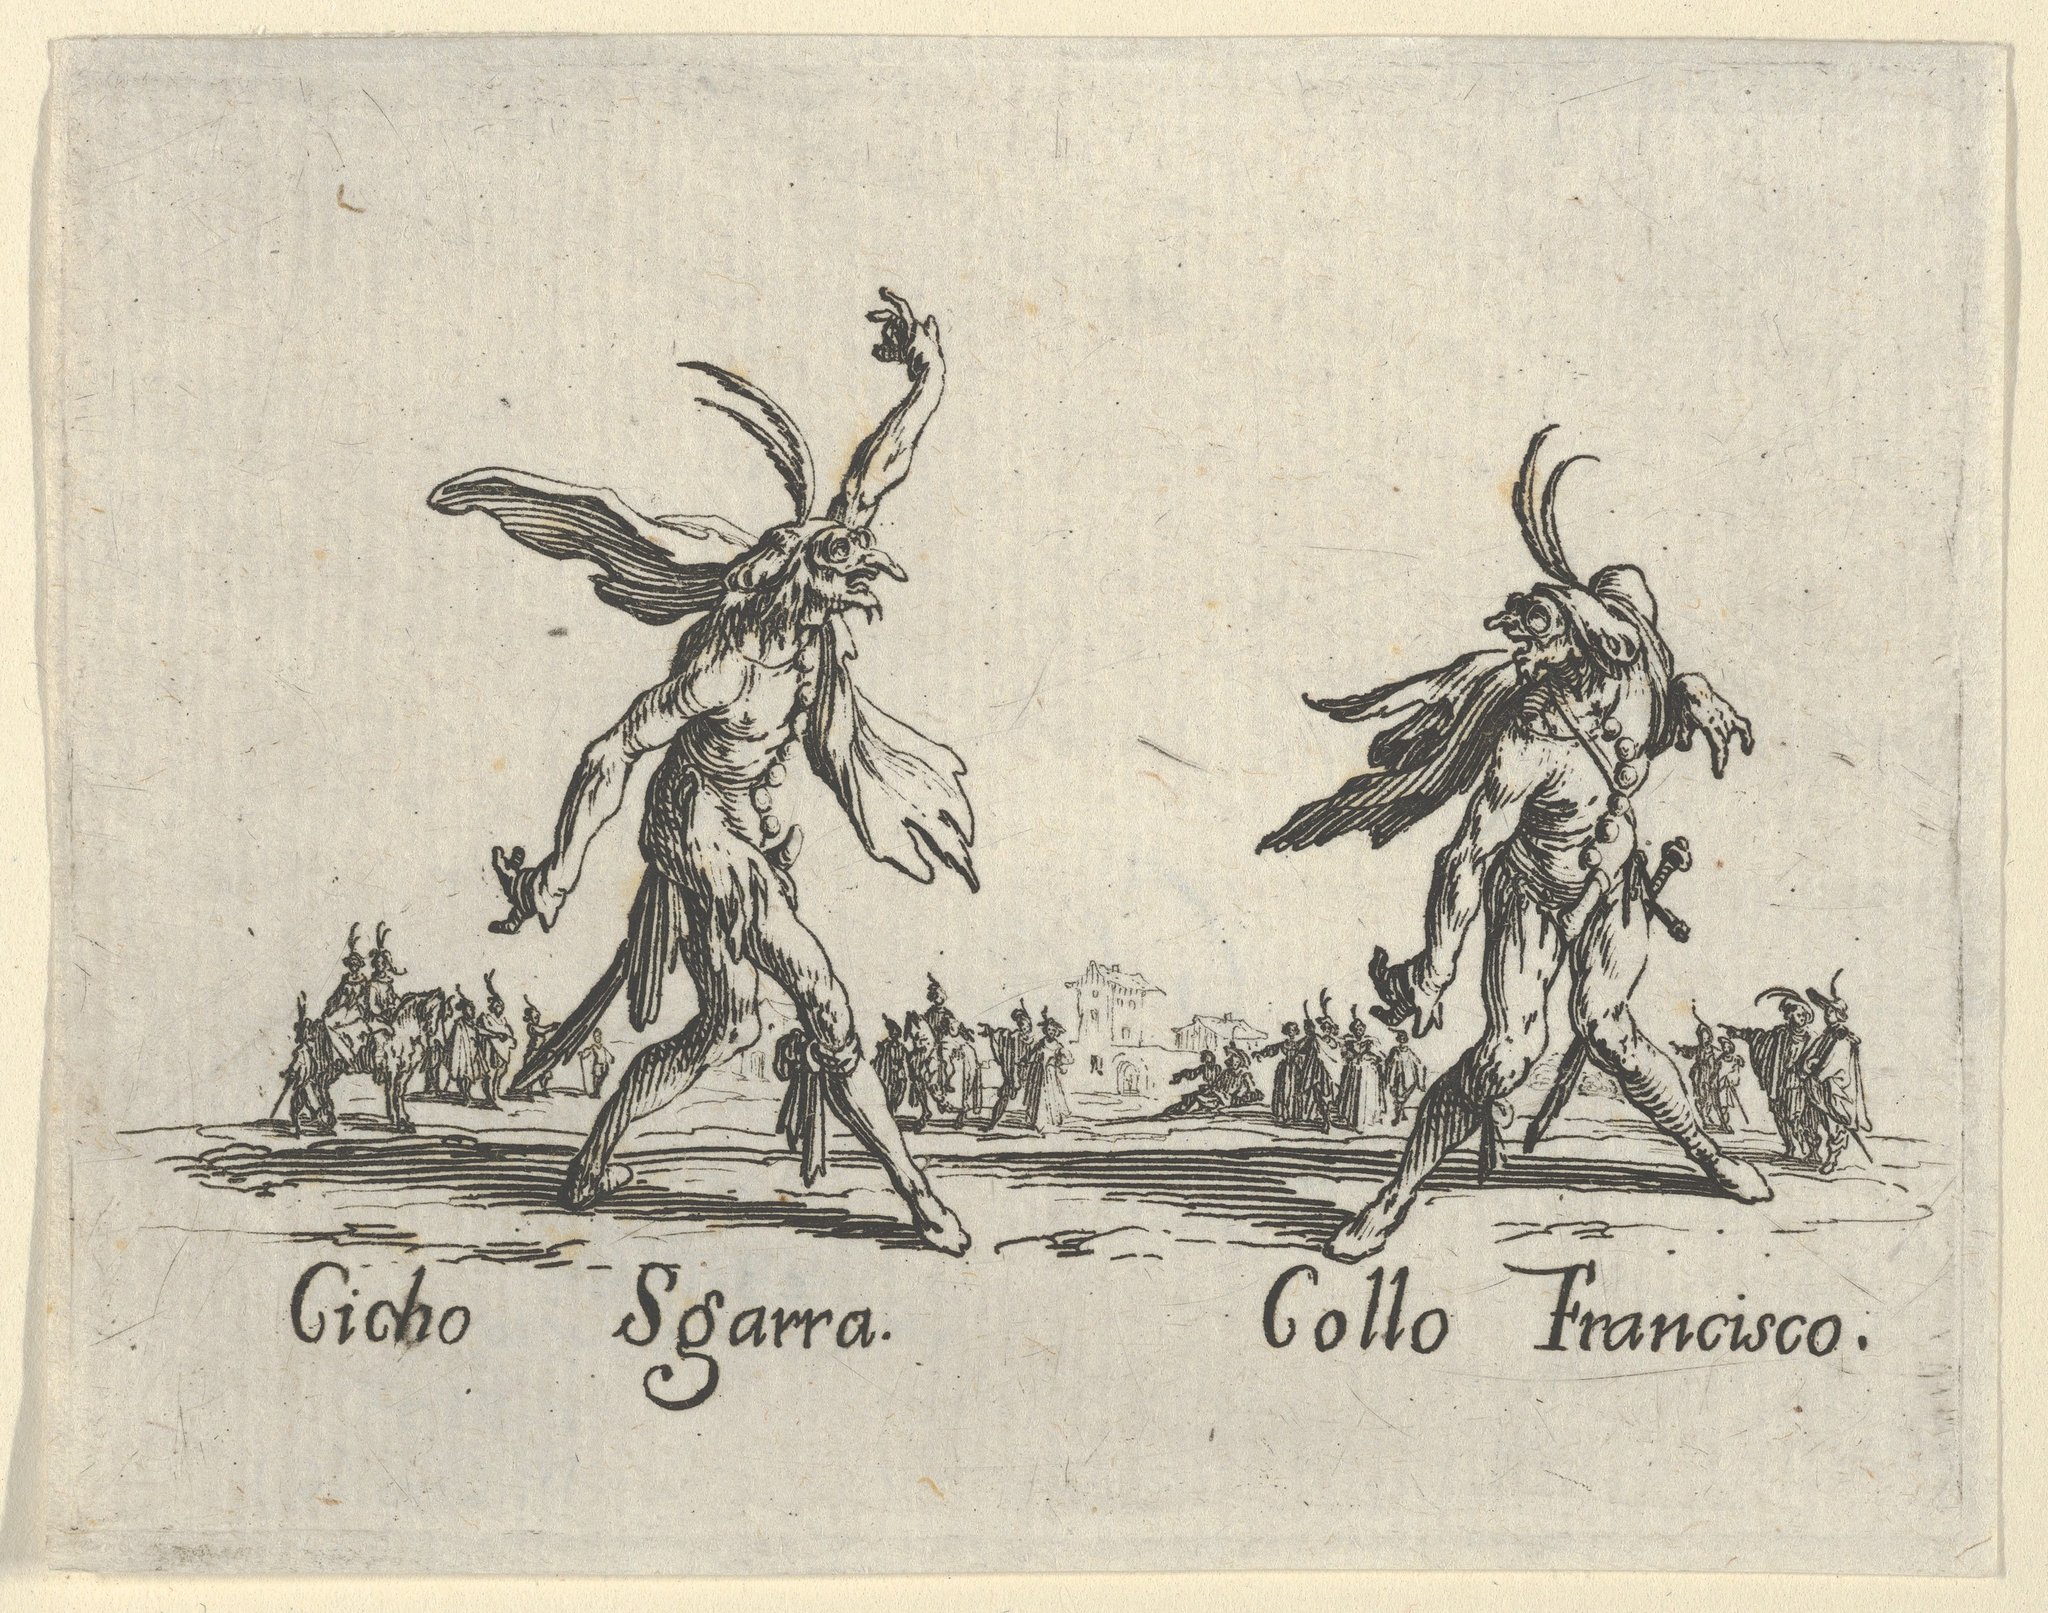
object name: print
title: Cicho Sgarra - Collo Francisco, from "Balli di Sfessania" (Dance of Sfessania)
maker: jacques callot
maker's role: artist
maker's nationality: french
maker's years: 1592-1635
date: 1622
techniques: etching